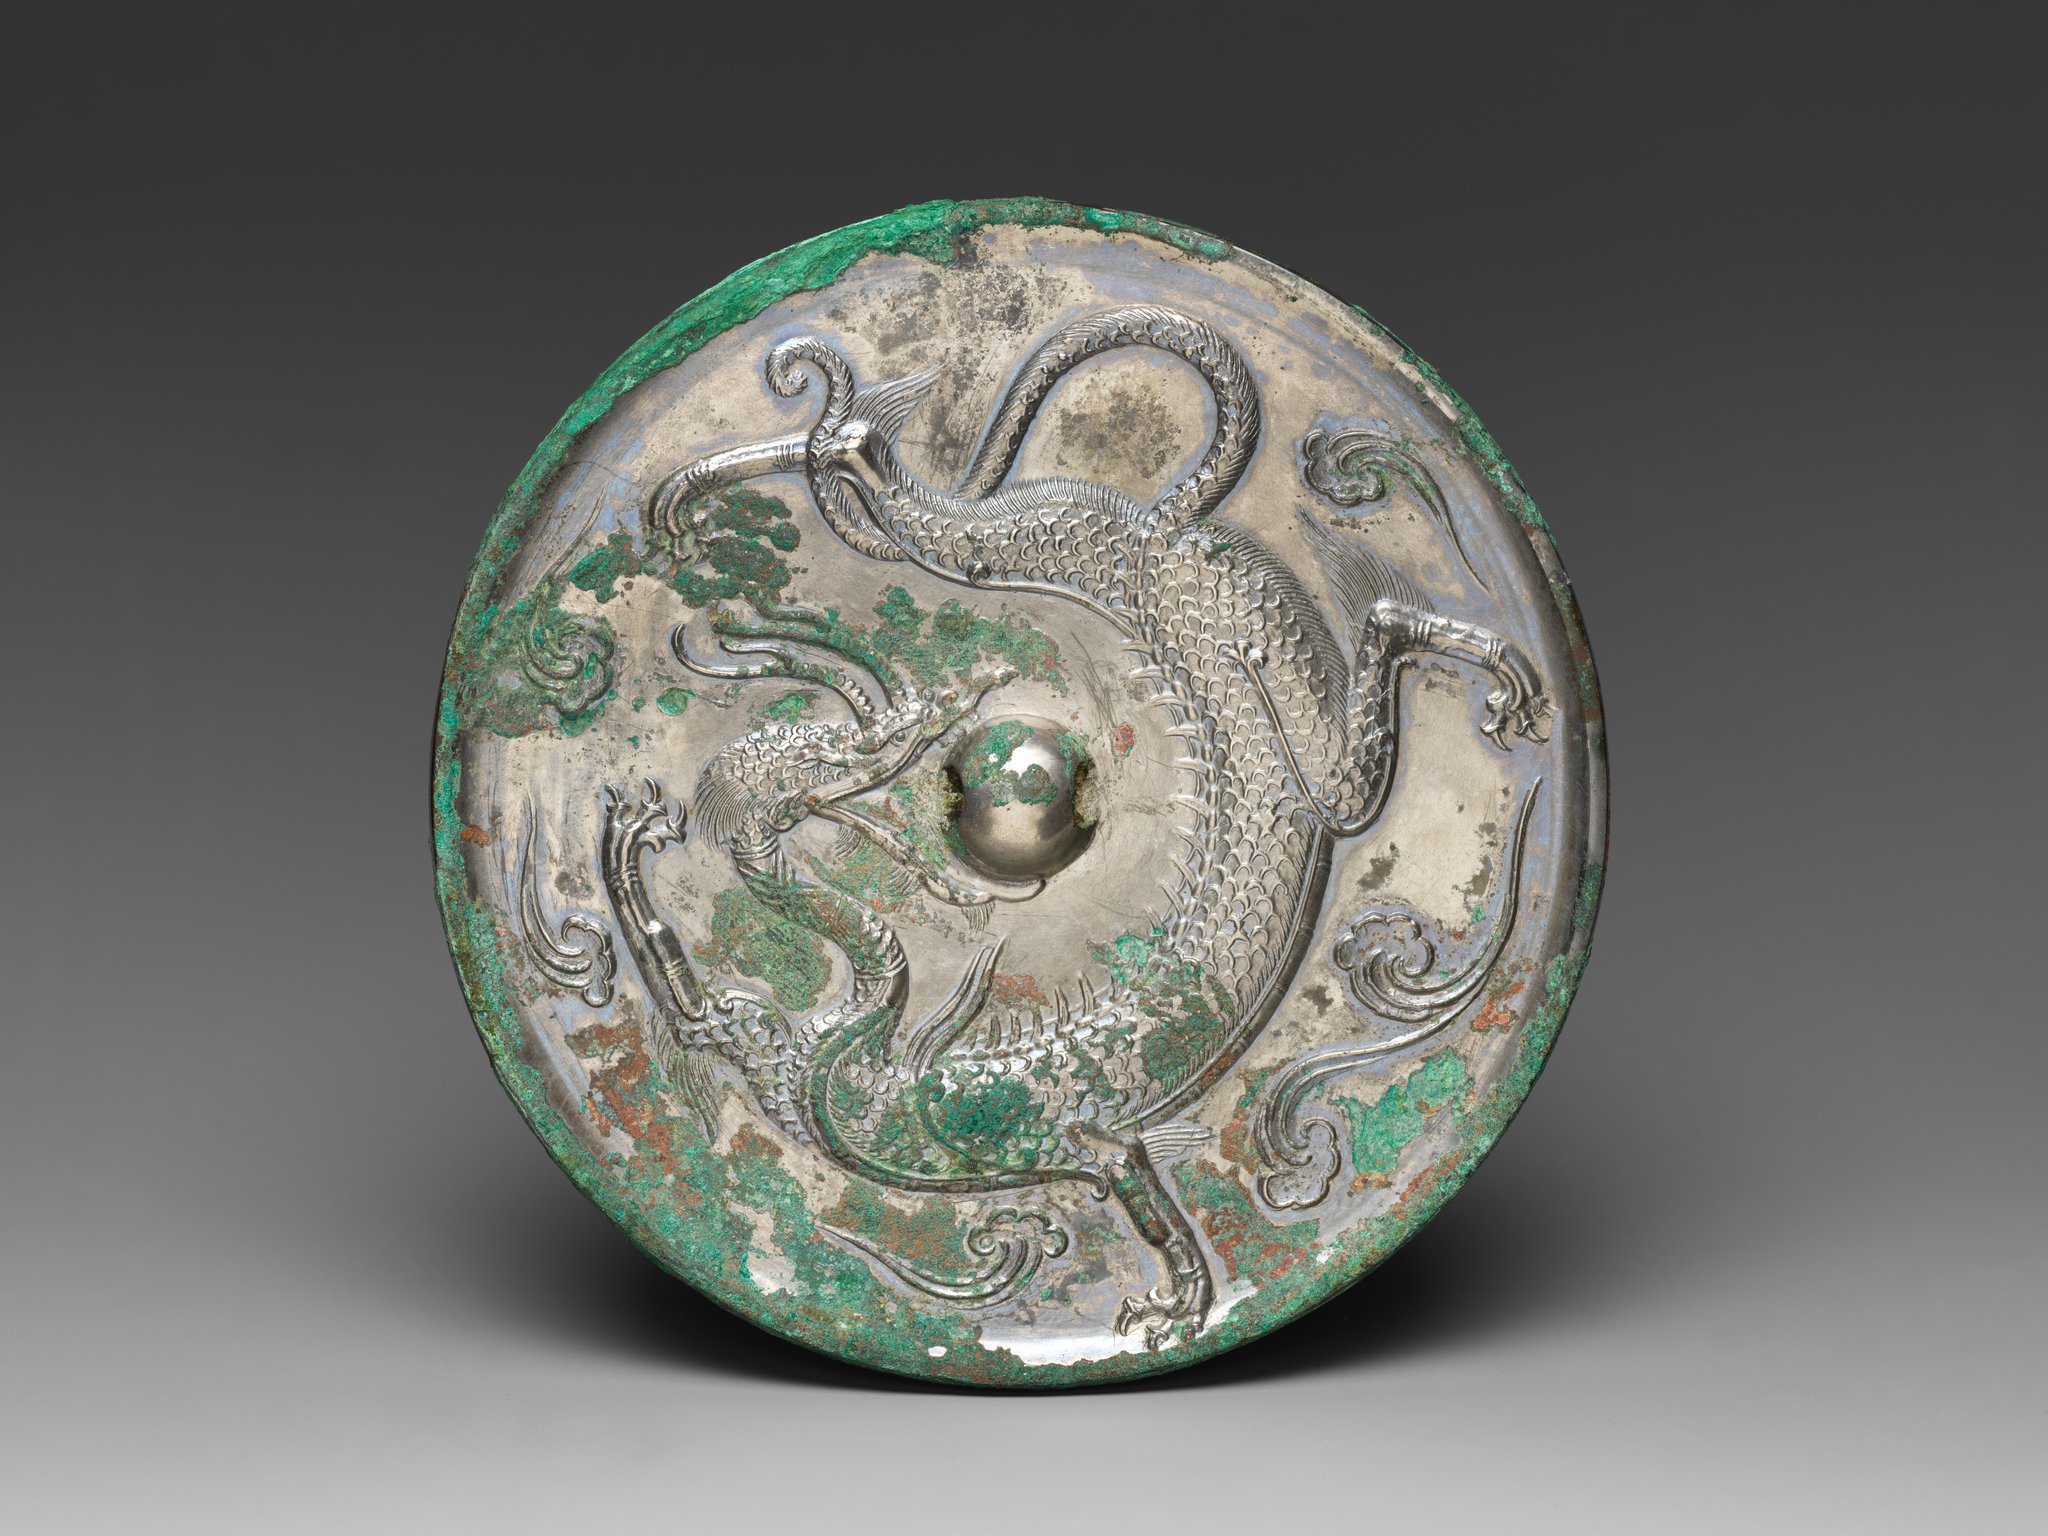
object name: mirror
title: Mirror with dragon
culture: chinese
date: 701-900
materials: bronze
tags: dragons